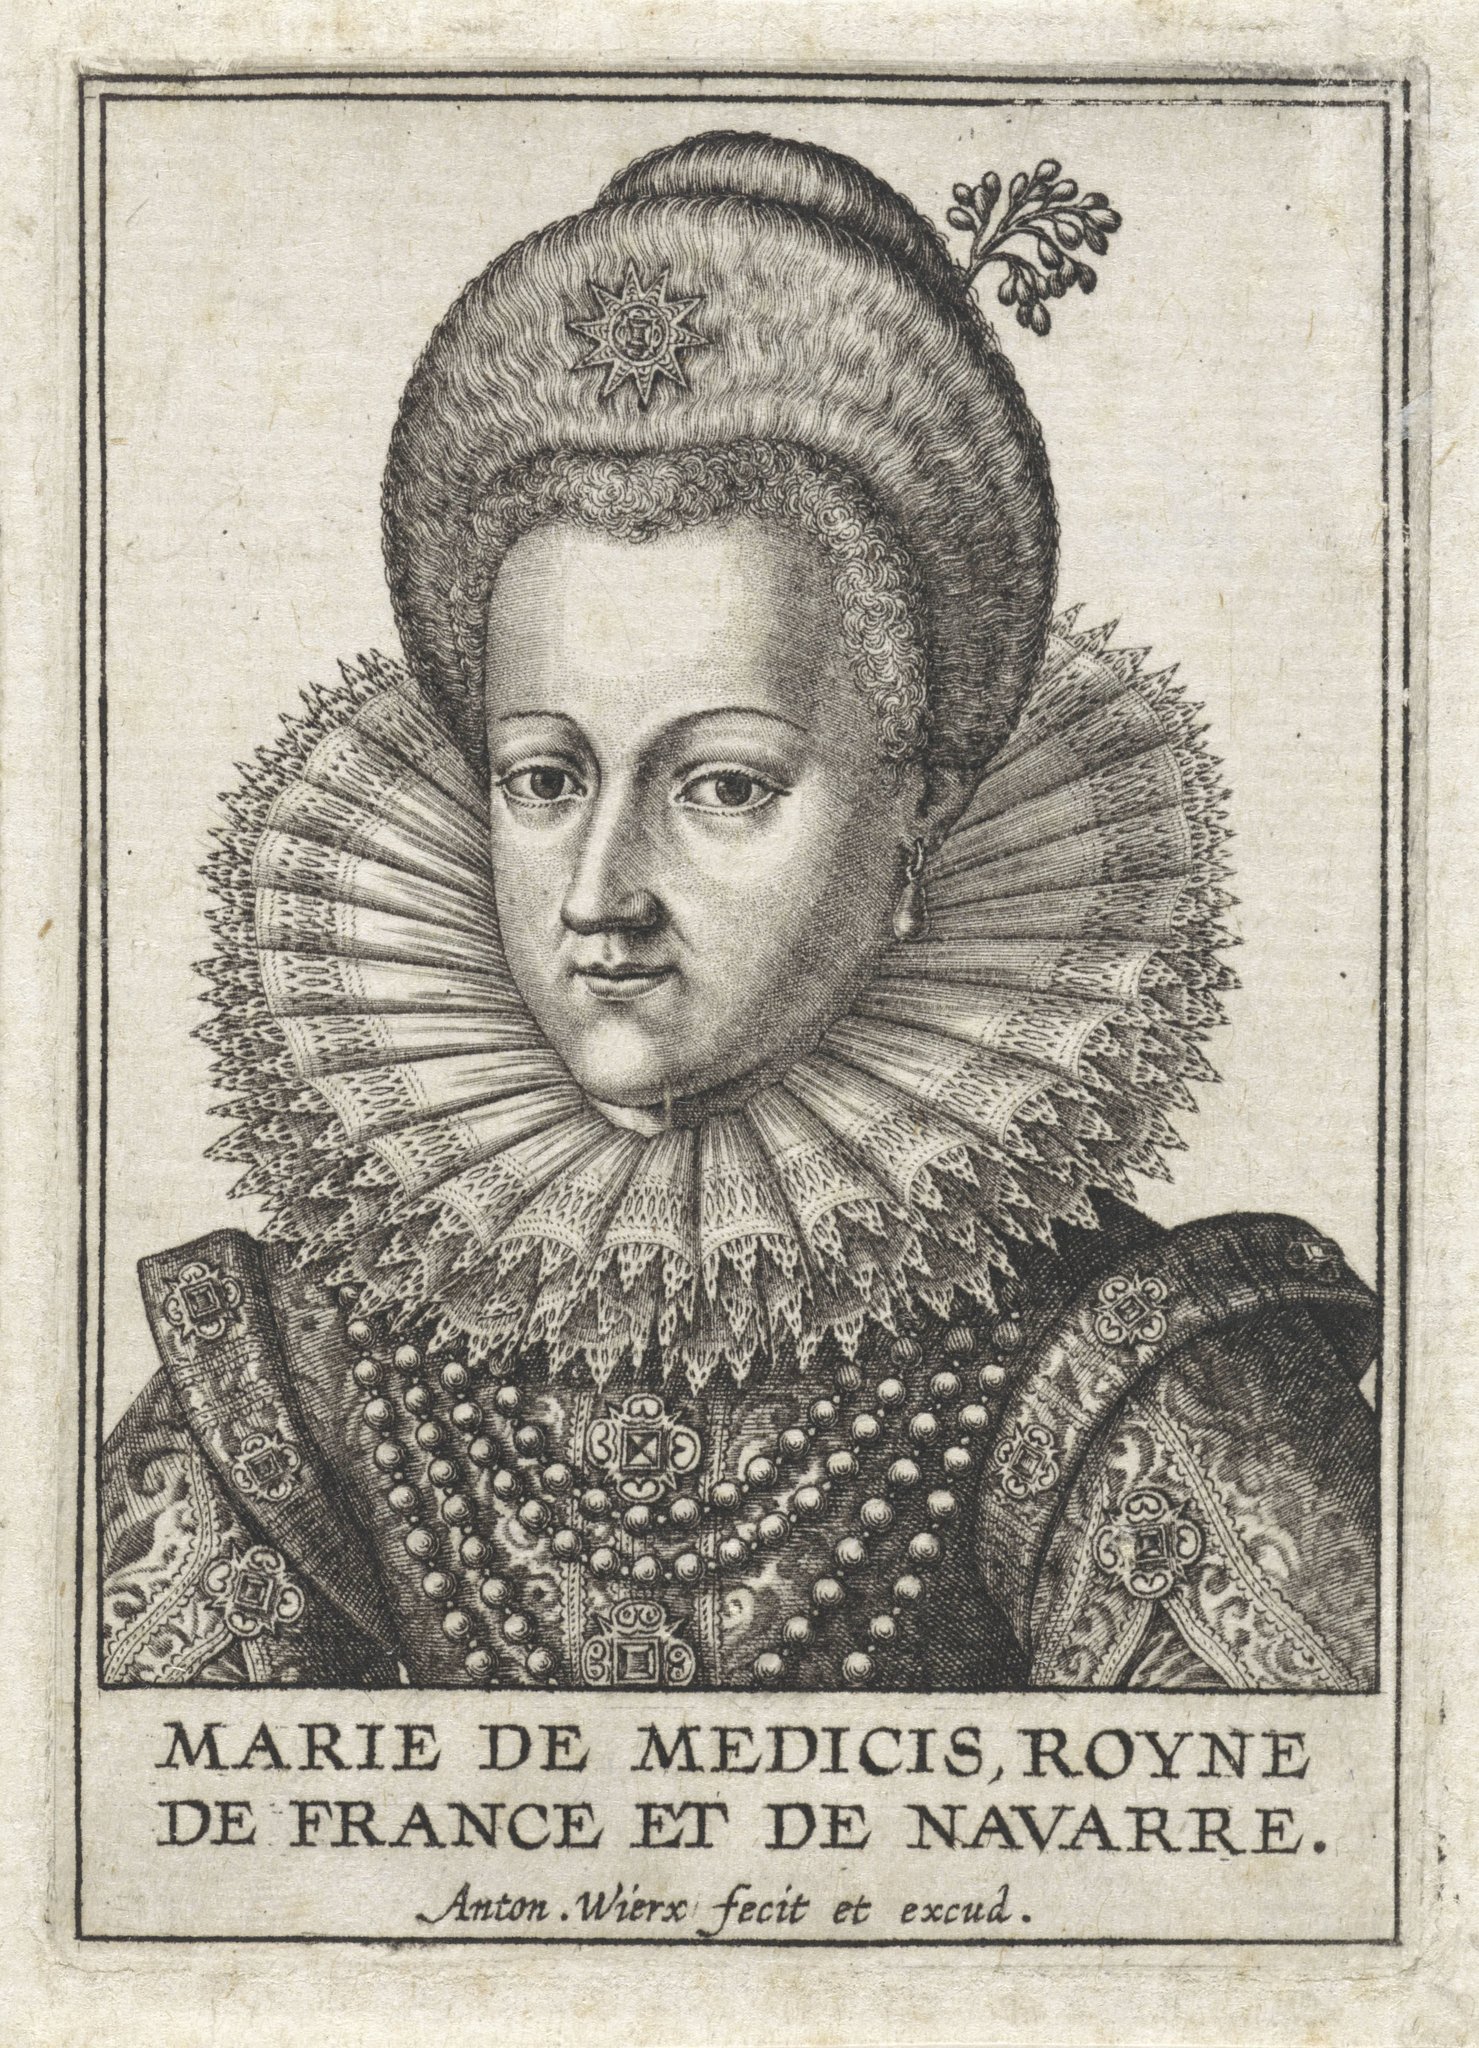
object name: print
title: Busteportret van Maria de' Medici, koningin van Frankrijk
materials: paper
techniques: engraving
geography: antwerp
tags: maria de' medici, pearl; pearl necklace (+ women's clothes)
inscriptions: collector's mark: Lugt 130, collector's mark: Lugt 2228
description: In de marge een tweeregelig onderschrift in het Frans.